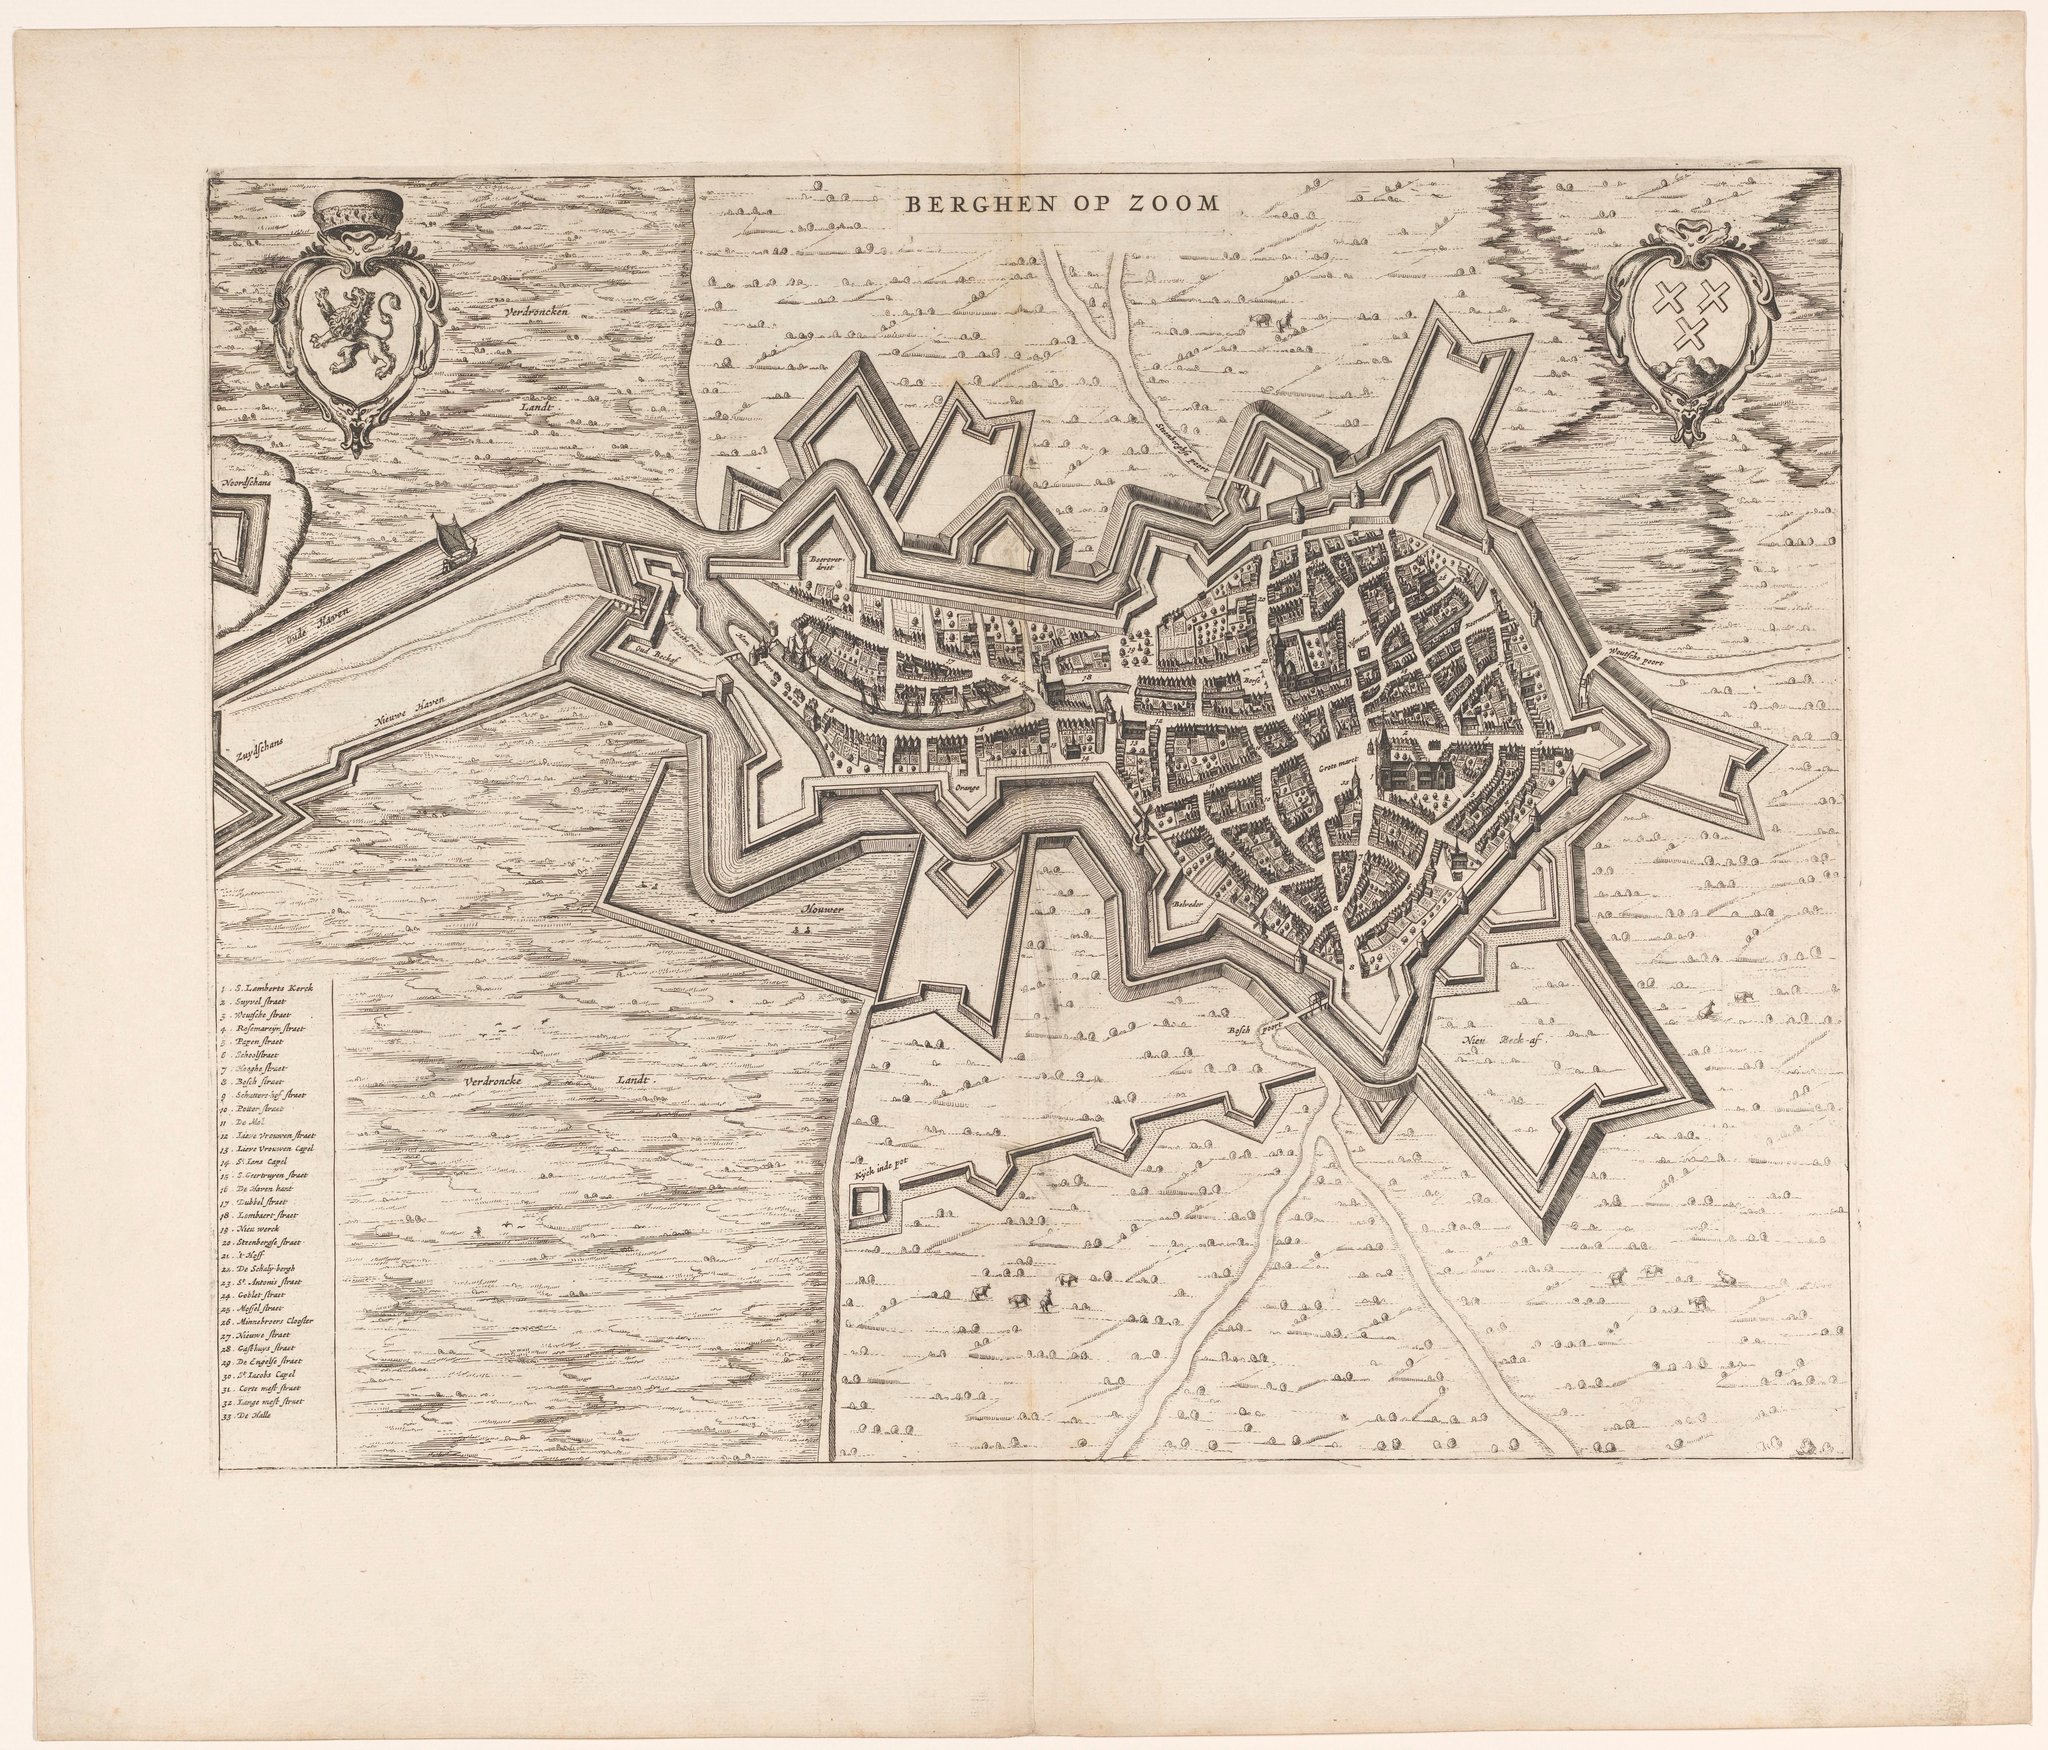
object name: area plan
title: Berghen op Zoom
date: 1652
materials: paper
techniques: engraving, etching, letterpress printing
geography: amsterdam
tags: coat of arms (as symbol of the state, etc.) (+ city; municipal), fortified city, maps of cities, coat of arms (as symbol of the state, etc.) (+ province; provincial), bergen op zoom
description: Plattegrond in vogelvluchtperspectief. Boven in het midden de titel. Linksonder een legenda 1-33. Linksboven het wapen van Brabant. Rechtsboven het wapen van Bergen op Zoom. Op verso Latijnse tekst.